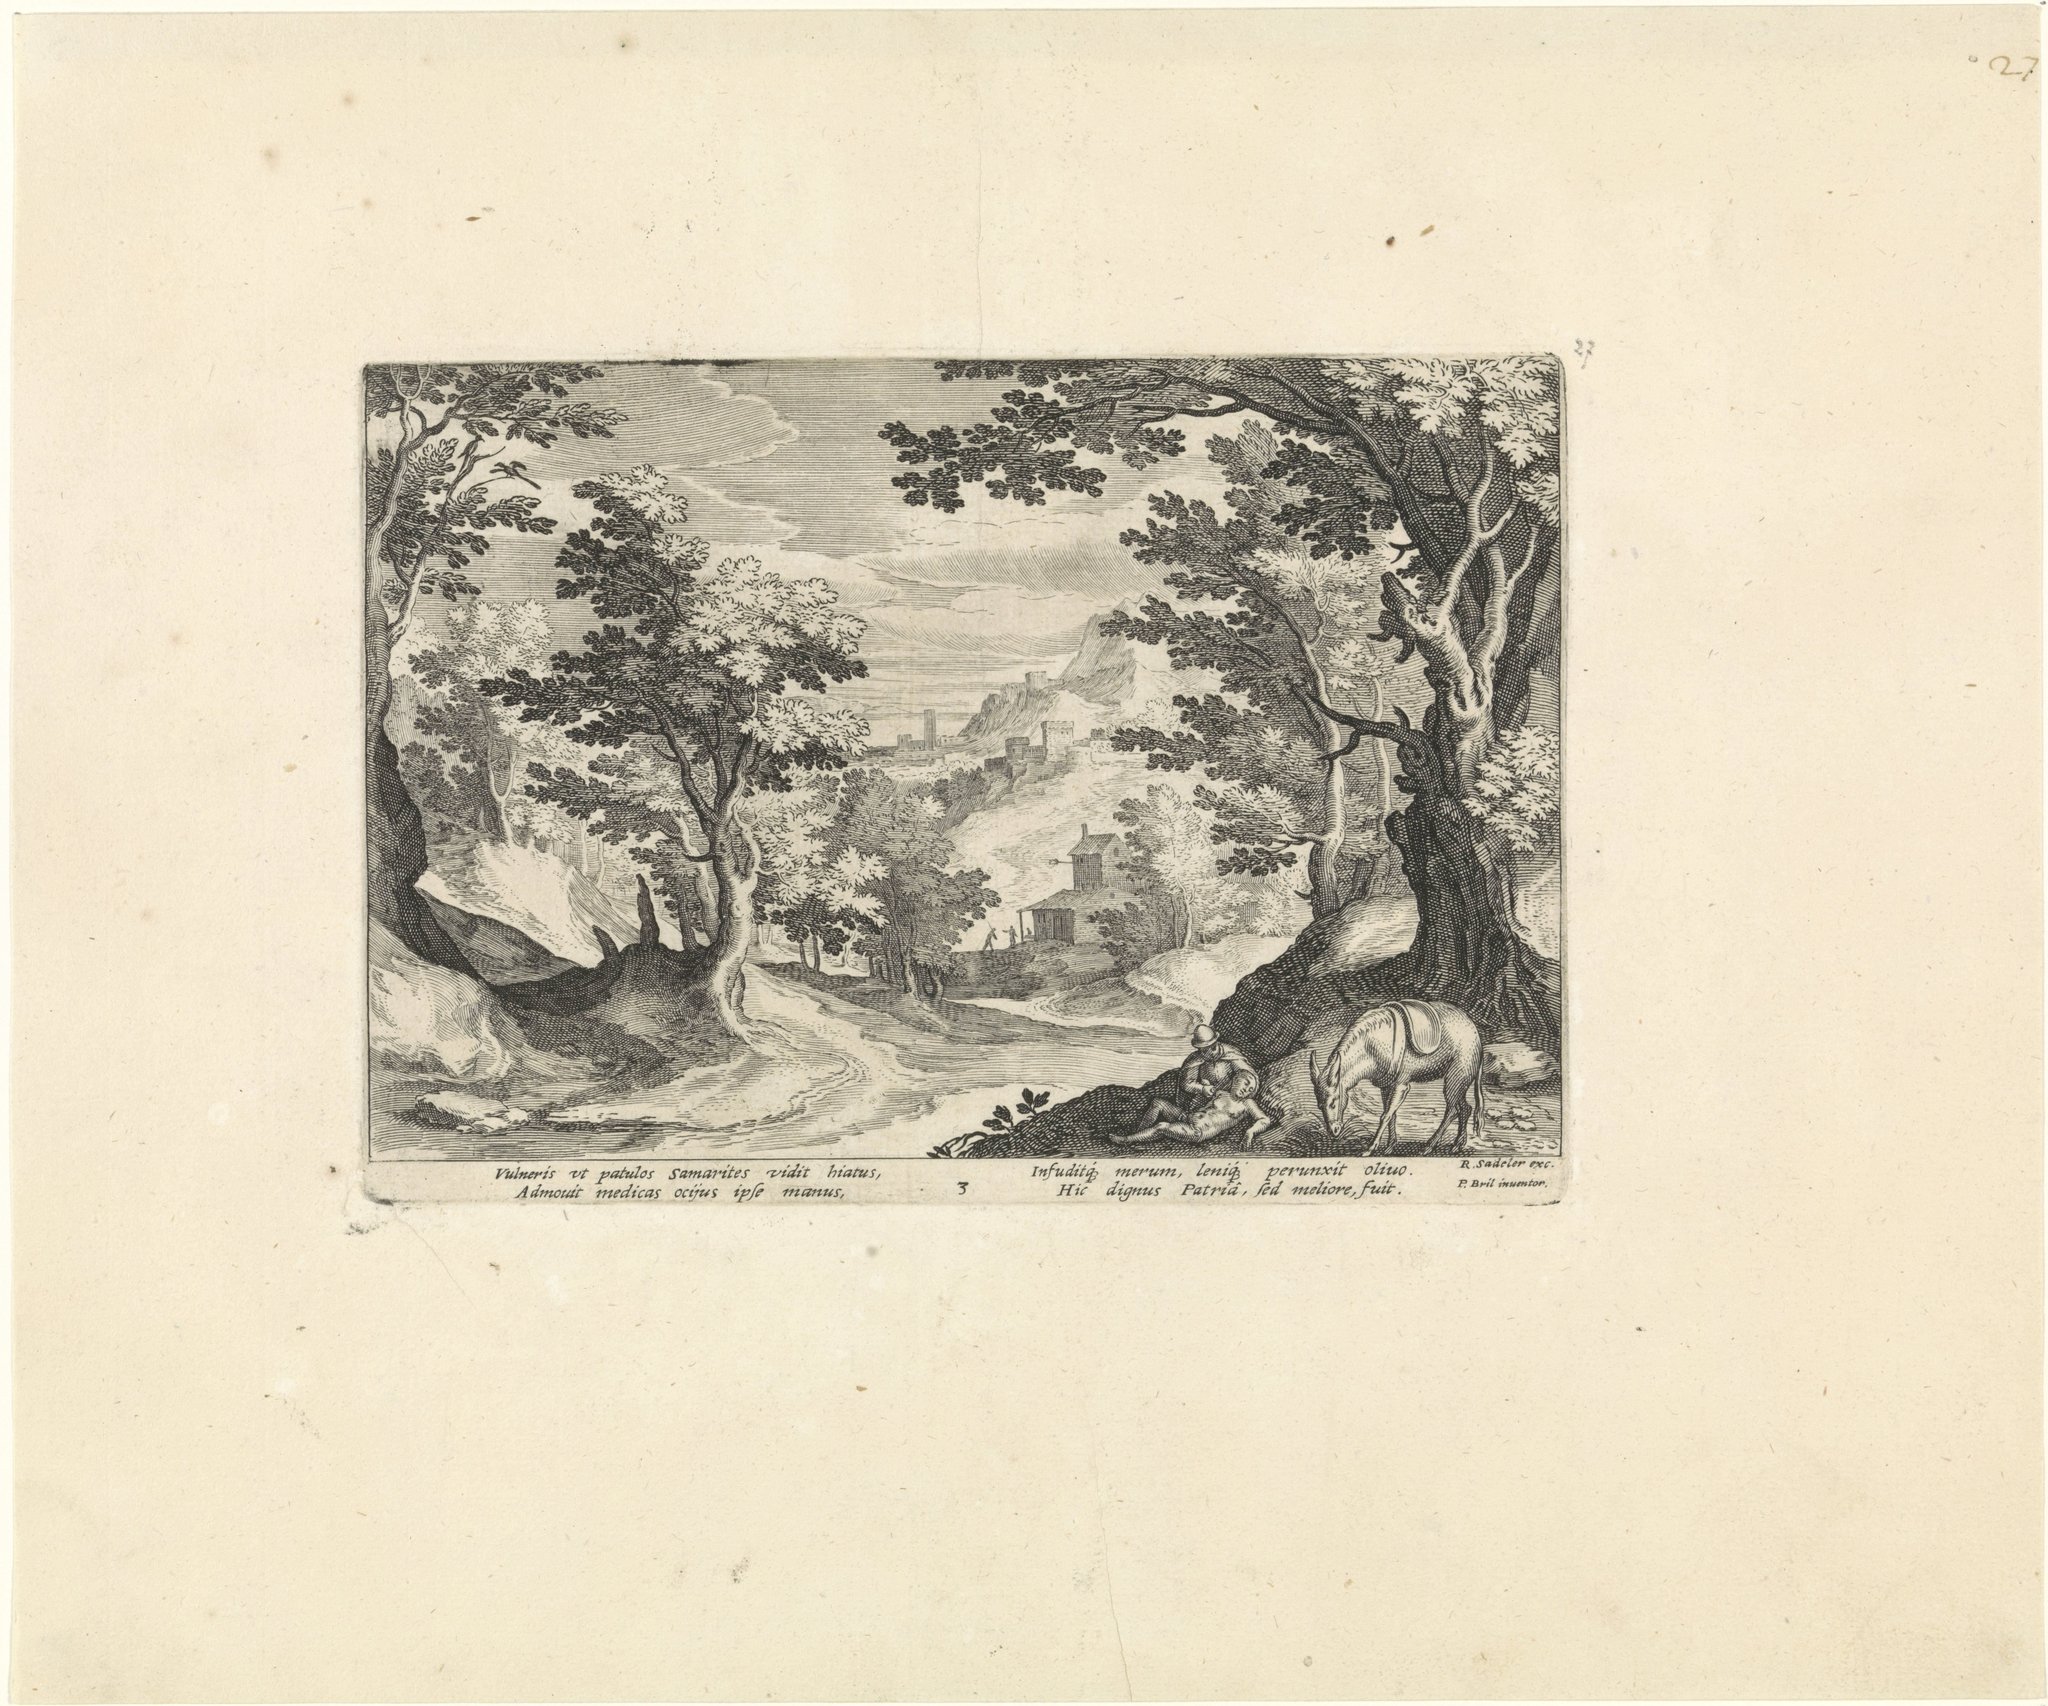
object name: print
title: Landschappen met scènes uit de gelijkenis van de barmhartige Samaritaan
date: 1594-1632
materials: paper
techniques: engraving, etching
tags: forest, wood, a samaritan tending the wounds of the traveller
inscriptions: number: ‘29’, collector's mark: Lugt 2760, collector's mark: Lugt 2228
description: Een boslandschap met een weg. Naast de weg ondersteunt de barmhartige Samaritaan de beroofde en gewonde man en verzorgt zijn wonden.